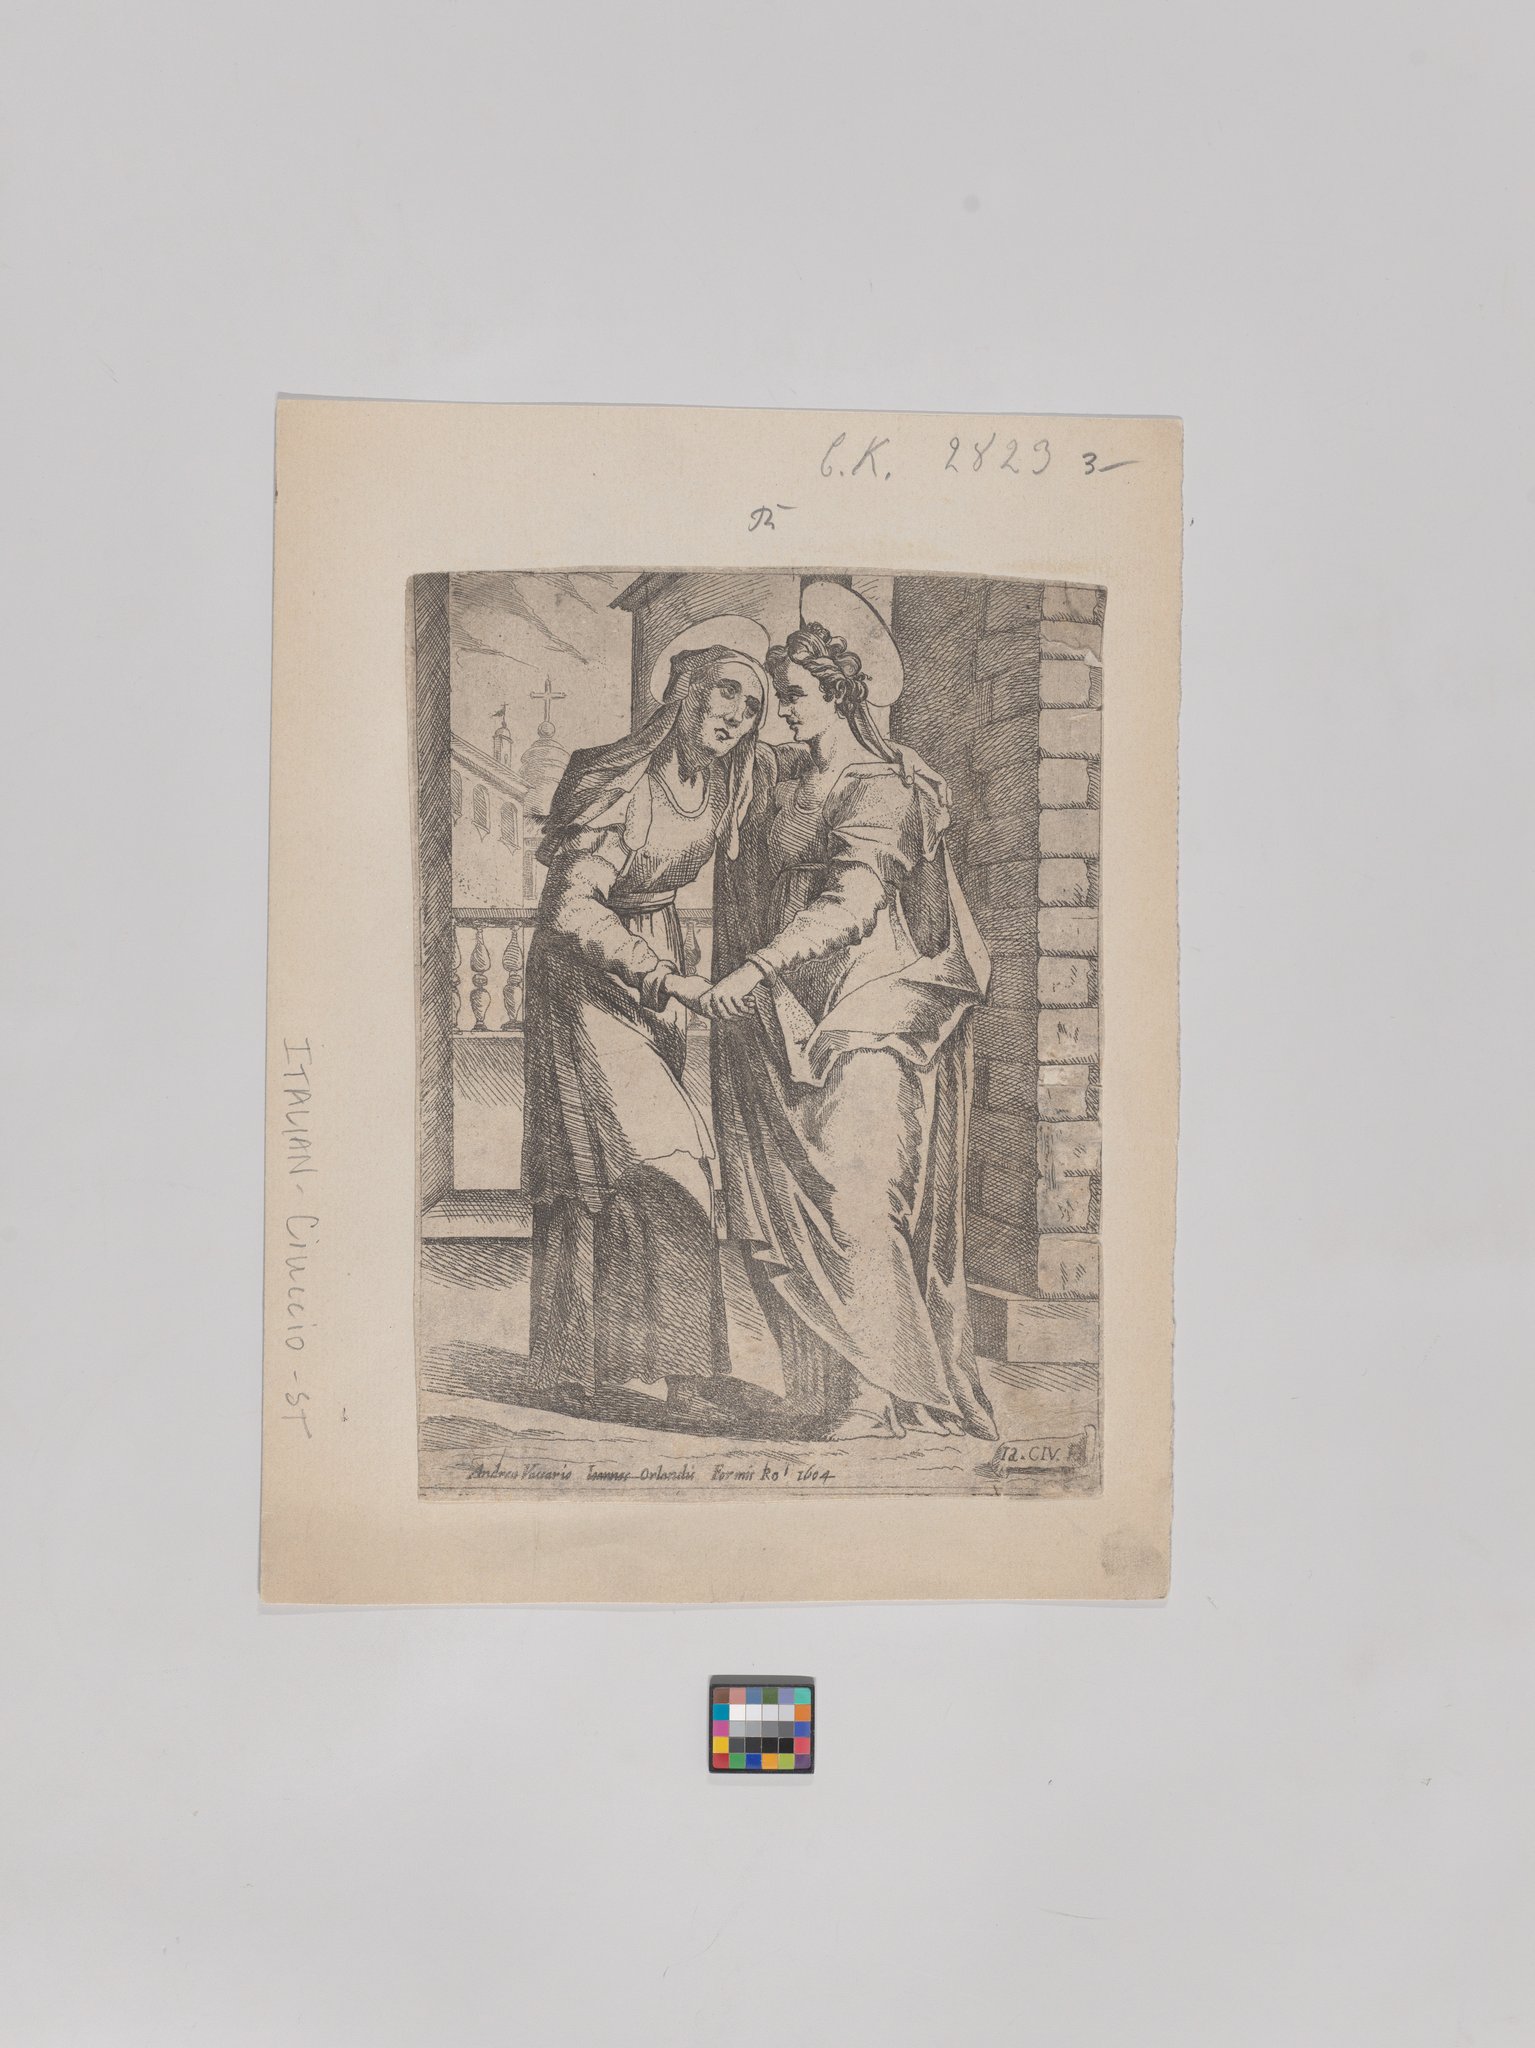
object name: print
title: The Visitation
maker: jacopo ciuccio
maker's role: artist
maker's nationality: italian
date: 1604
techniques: etching